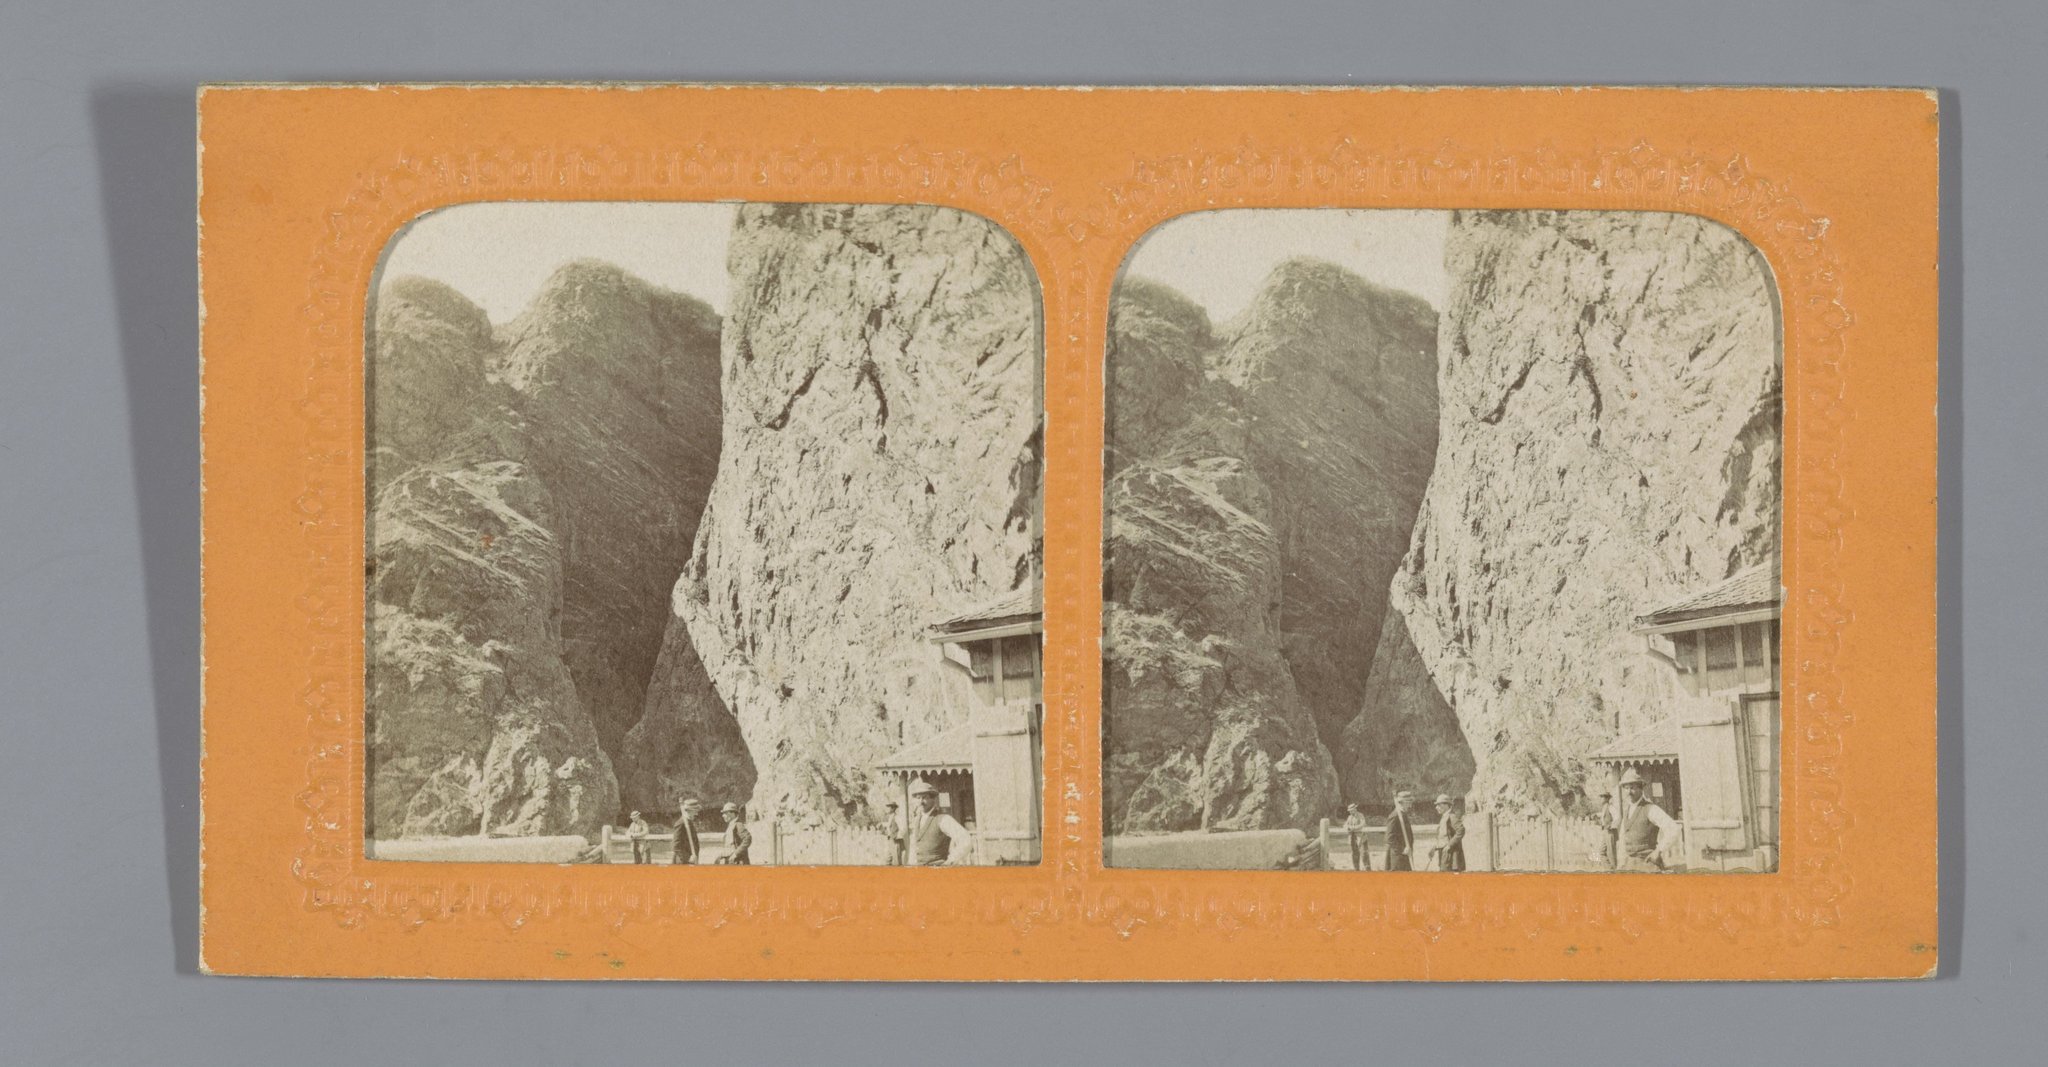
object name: tissue stereograph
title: Gorge du Trient, Suisse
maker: Anonymous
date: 1855-1875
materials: cardboard, paper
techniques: albumen print, hand coloring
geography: trent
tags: ravine, chasm, abyss, canyon, rock-formations (+ landscape with figures, staffage)